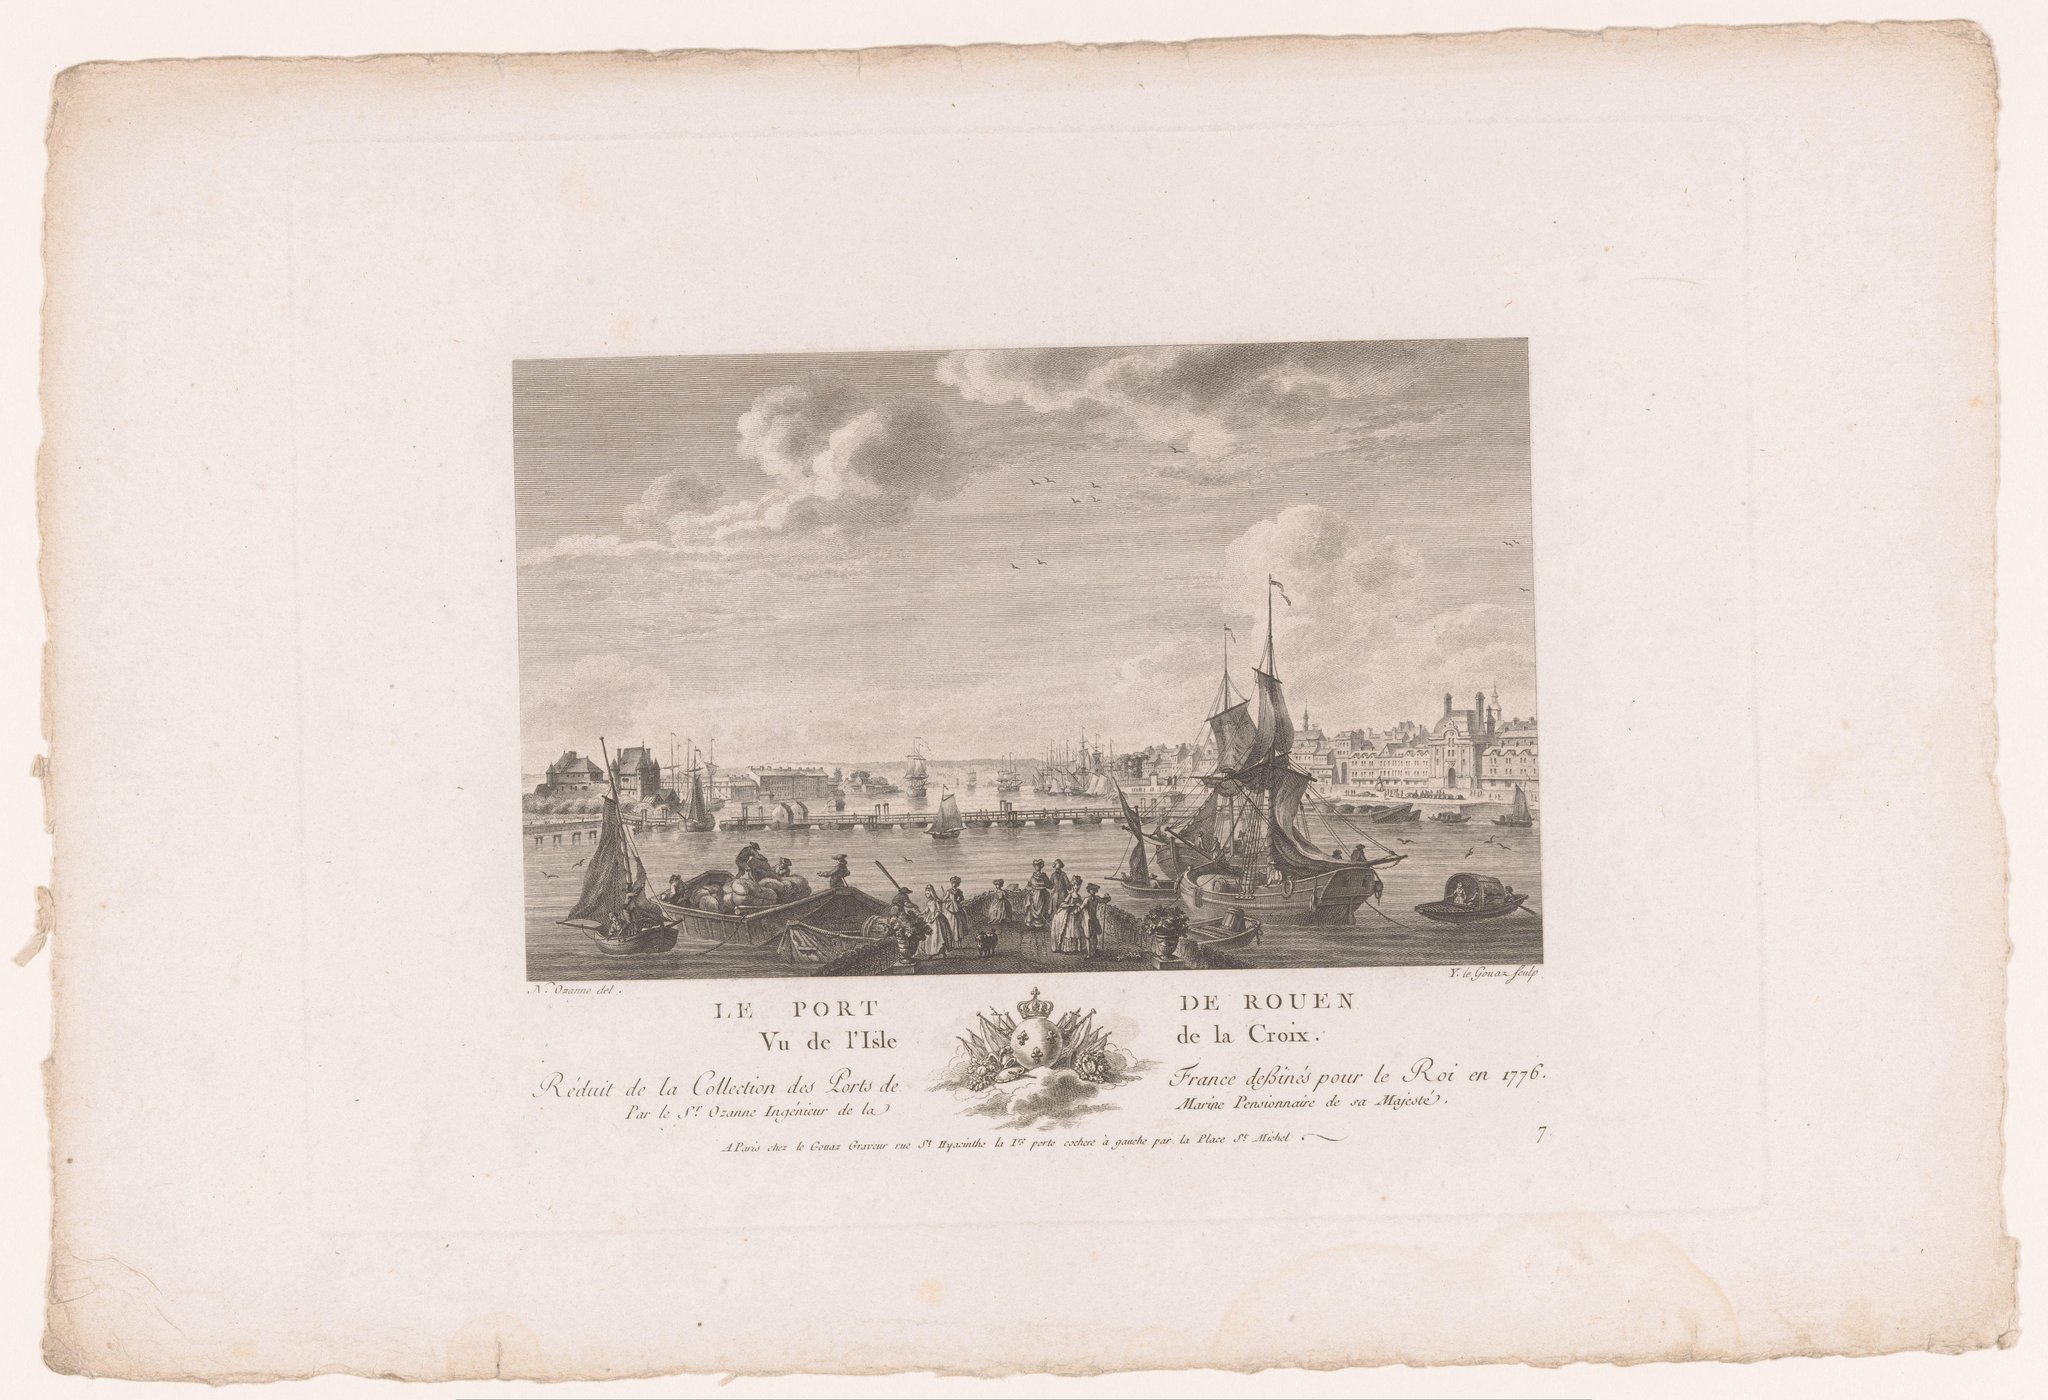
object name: print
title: Haven van Rouen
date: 1776-1816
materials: paper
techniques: engraving, etching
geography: paris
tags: harbour, armorial bearing, heraldry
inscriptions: collector's mark: Lugt 2228